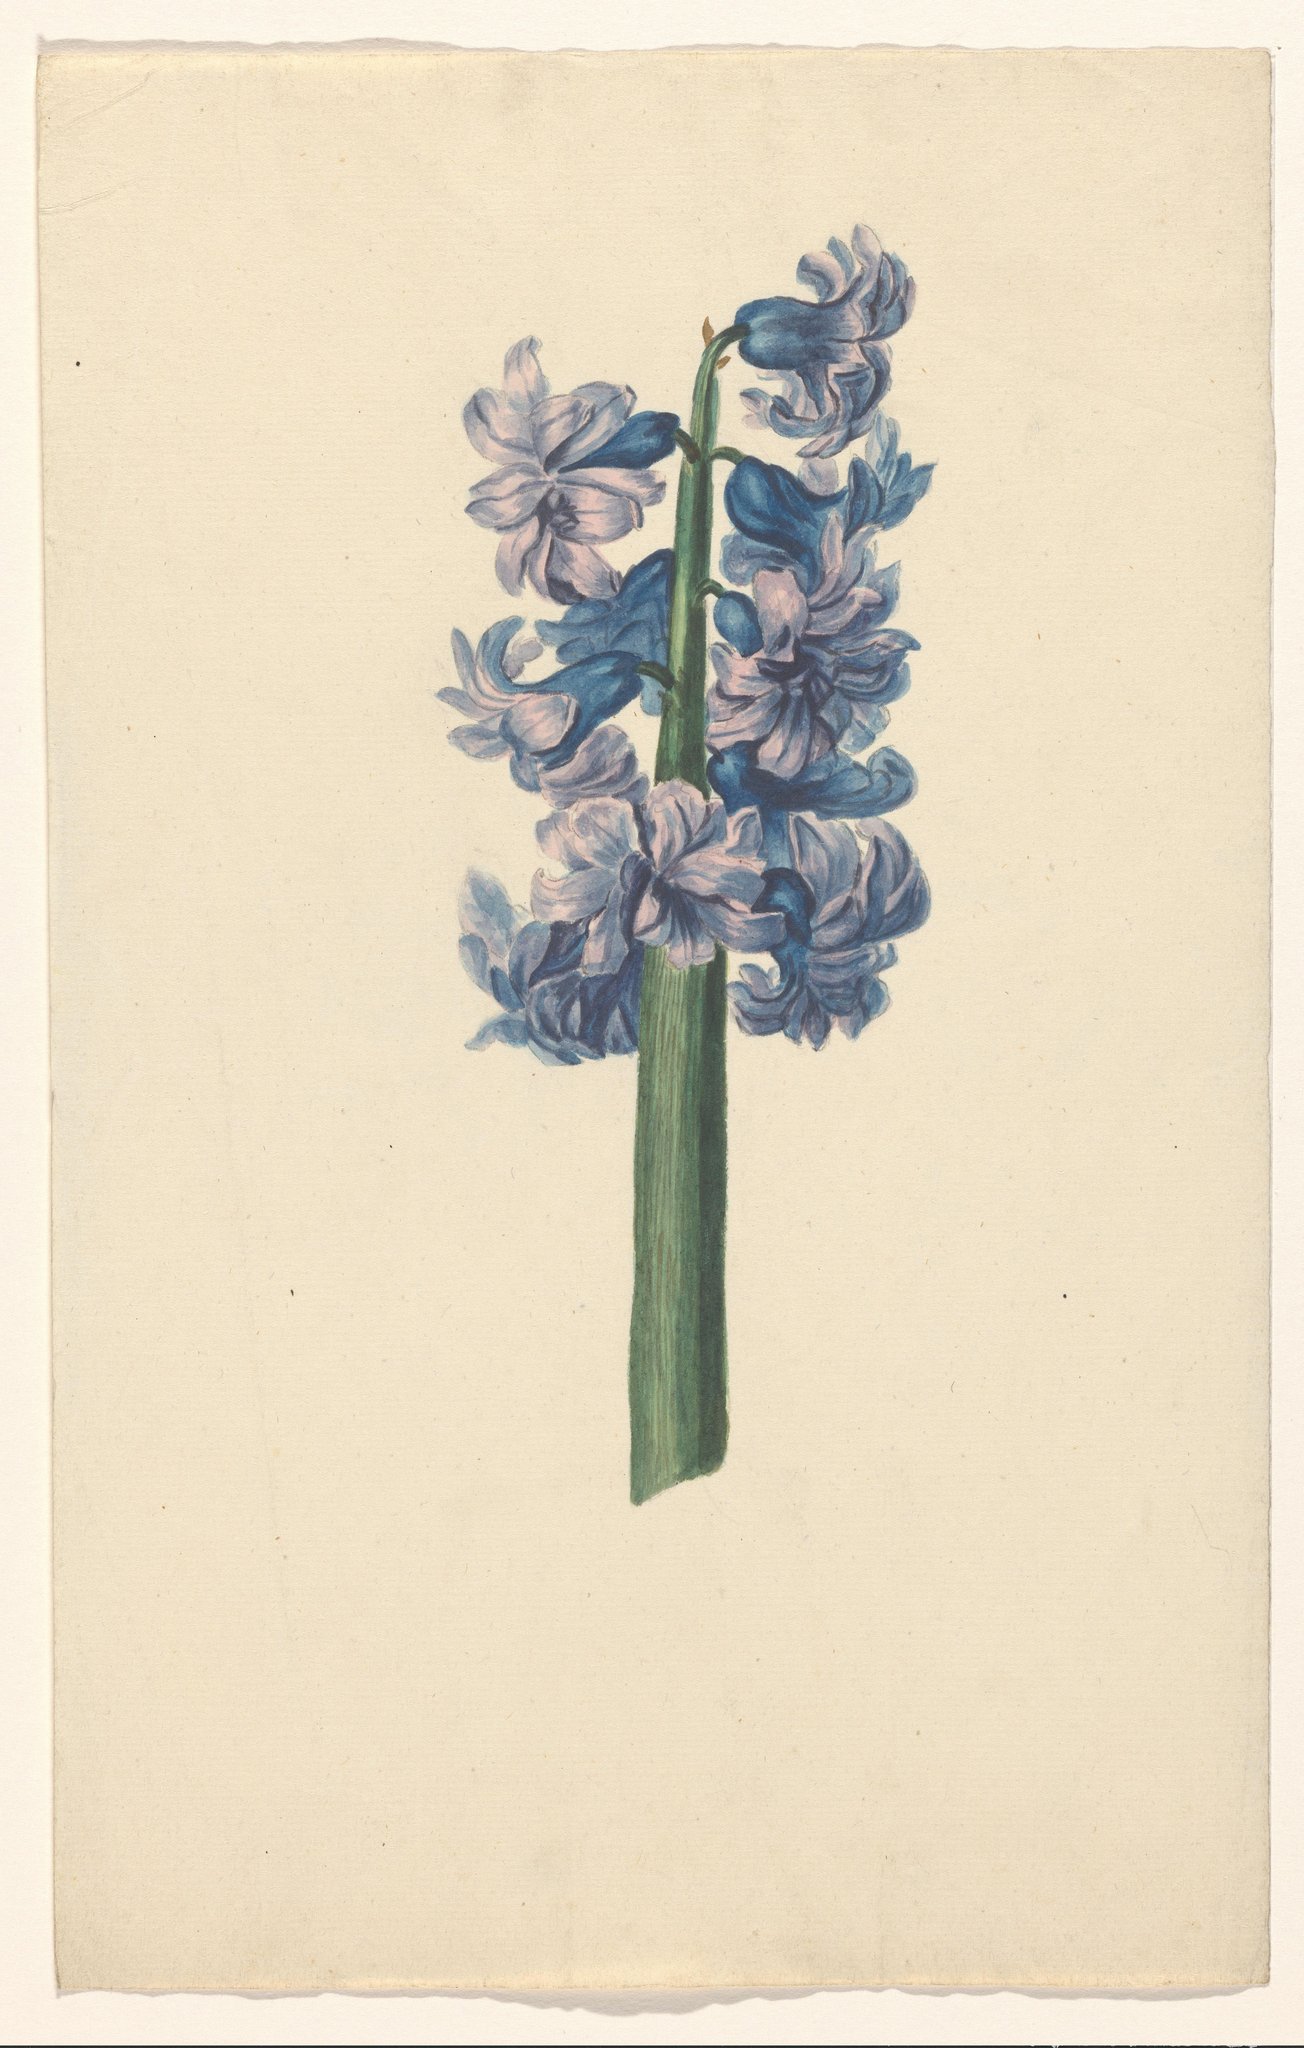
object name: drawing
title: Hyacint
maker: joannes carolus alberdingk thijm (jan)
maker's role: pater, schrijver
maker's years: 1847-1926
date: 1853-1880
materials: paper, pencil, watercolor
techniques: brush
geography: netherlands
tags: flowers: hyacinth